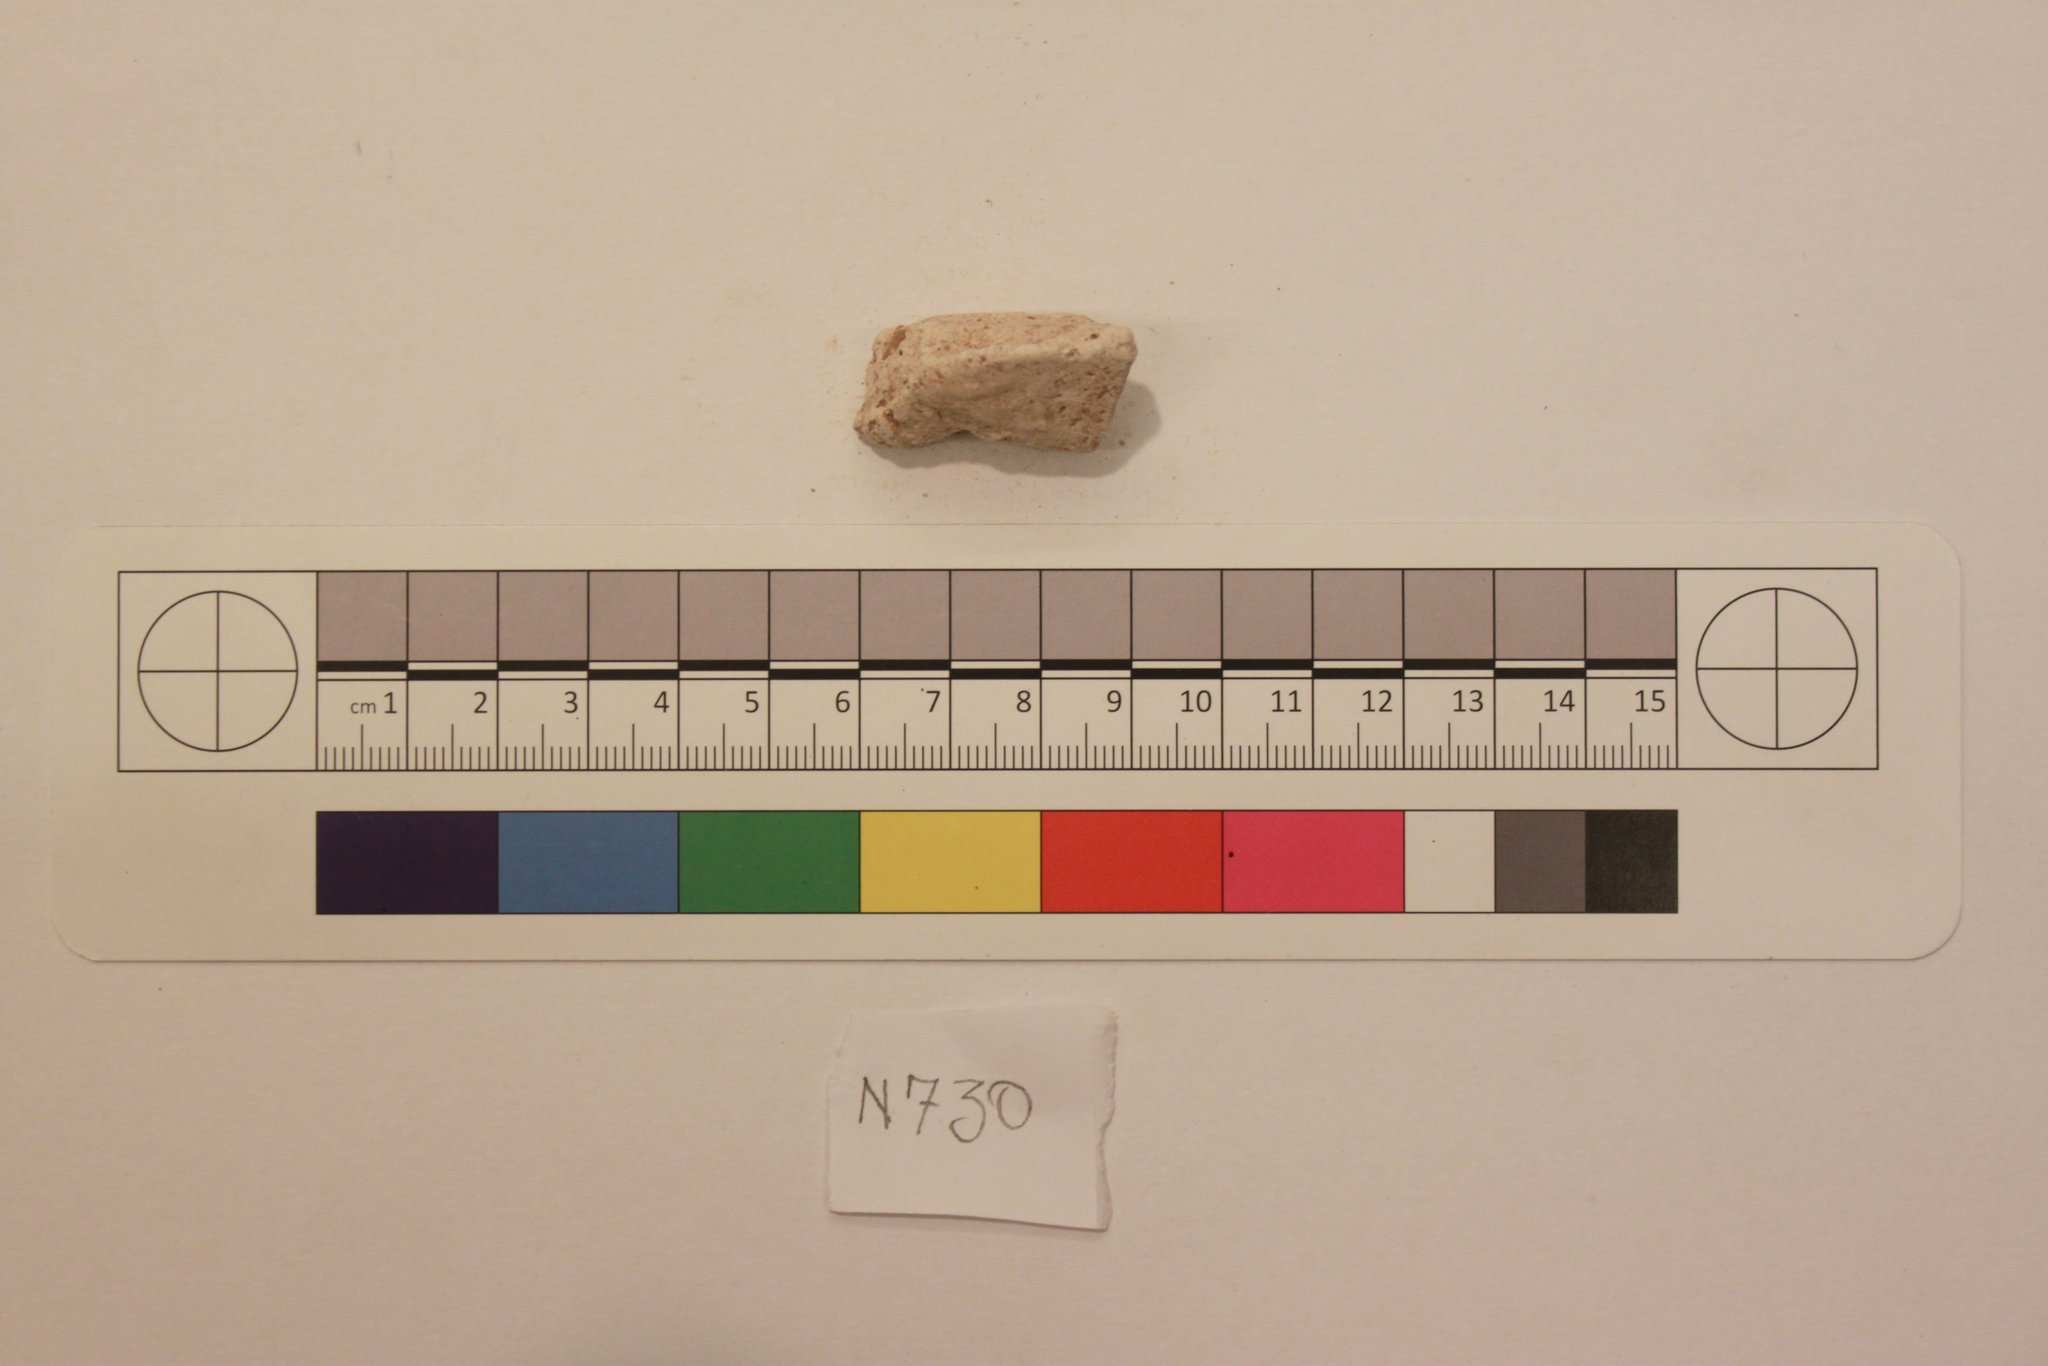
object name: fragment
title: Stucco Fragment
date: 701-1200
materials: plaster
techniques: carving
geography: iran